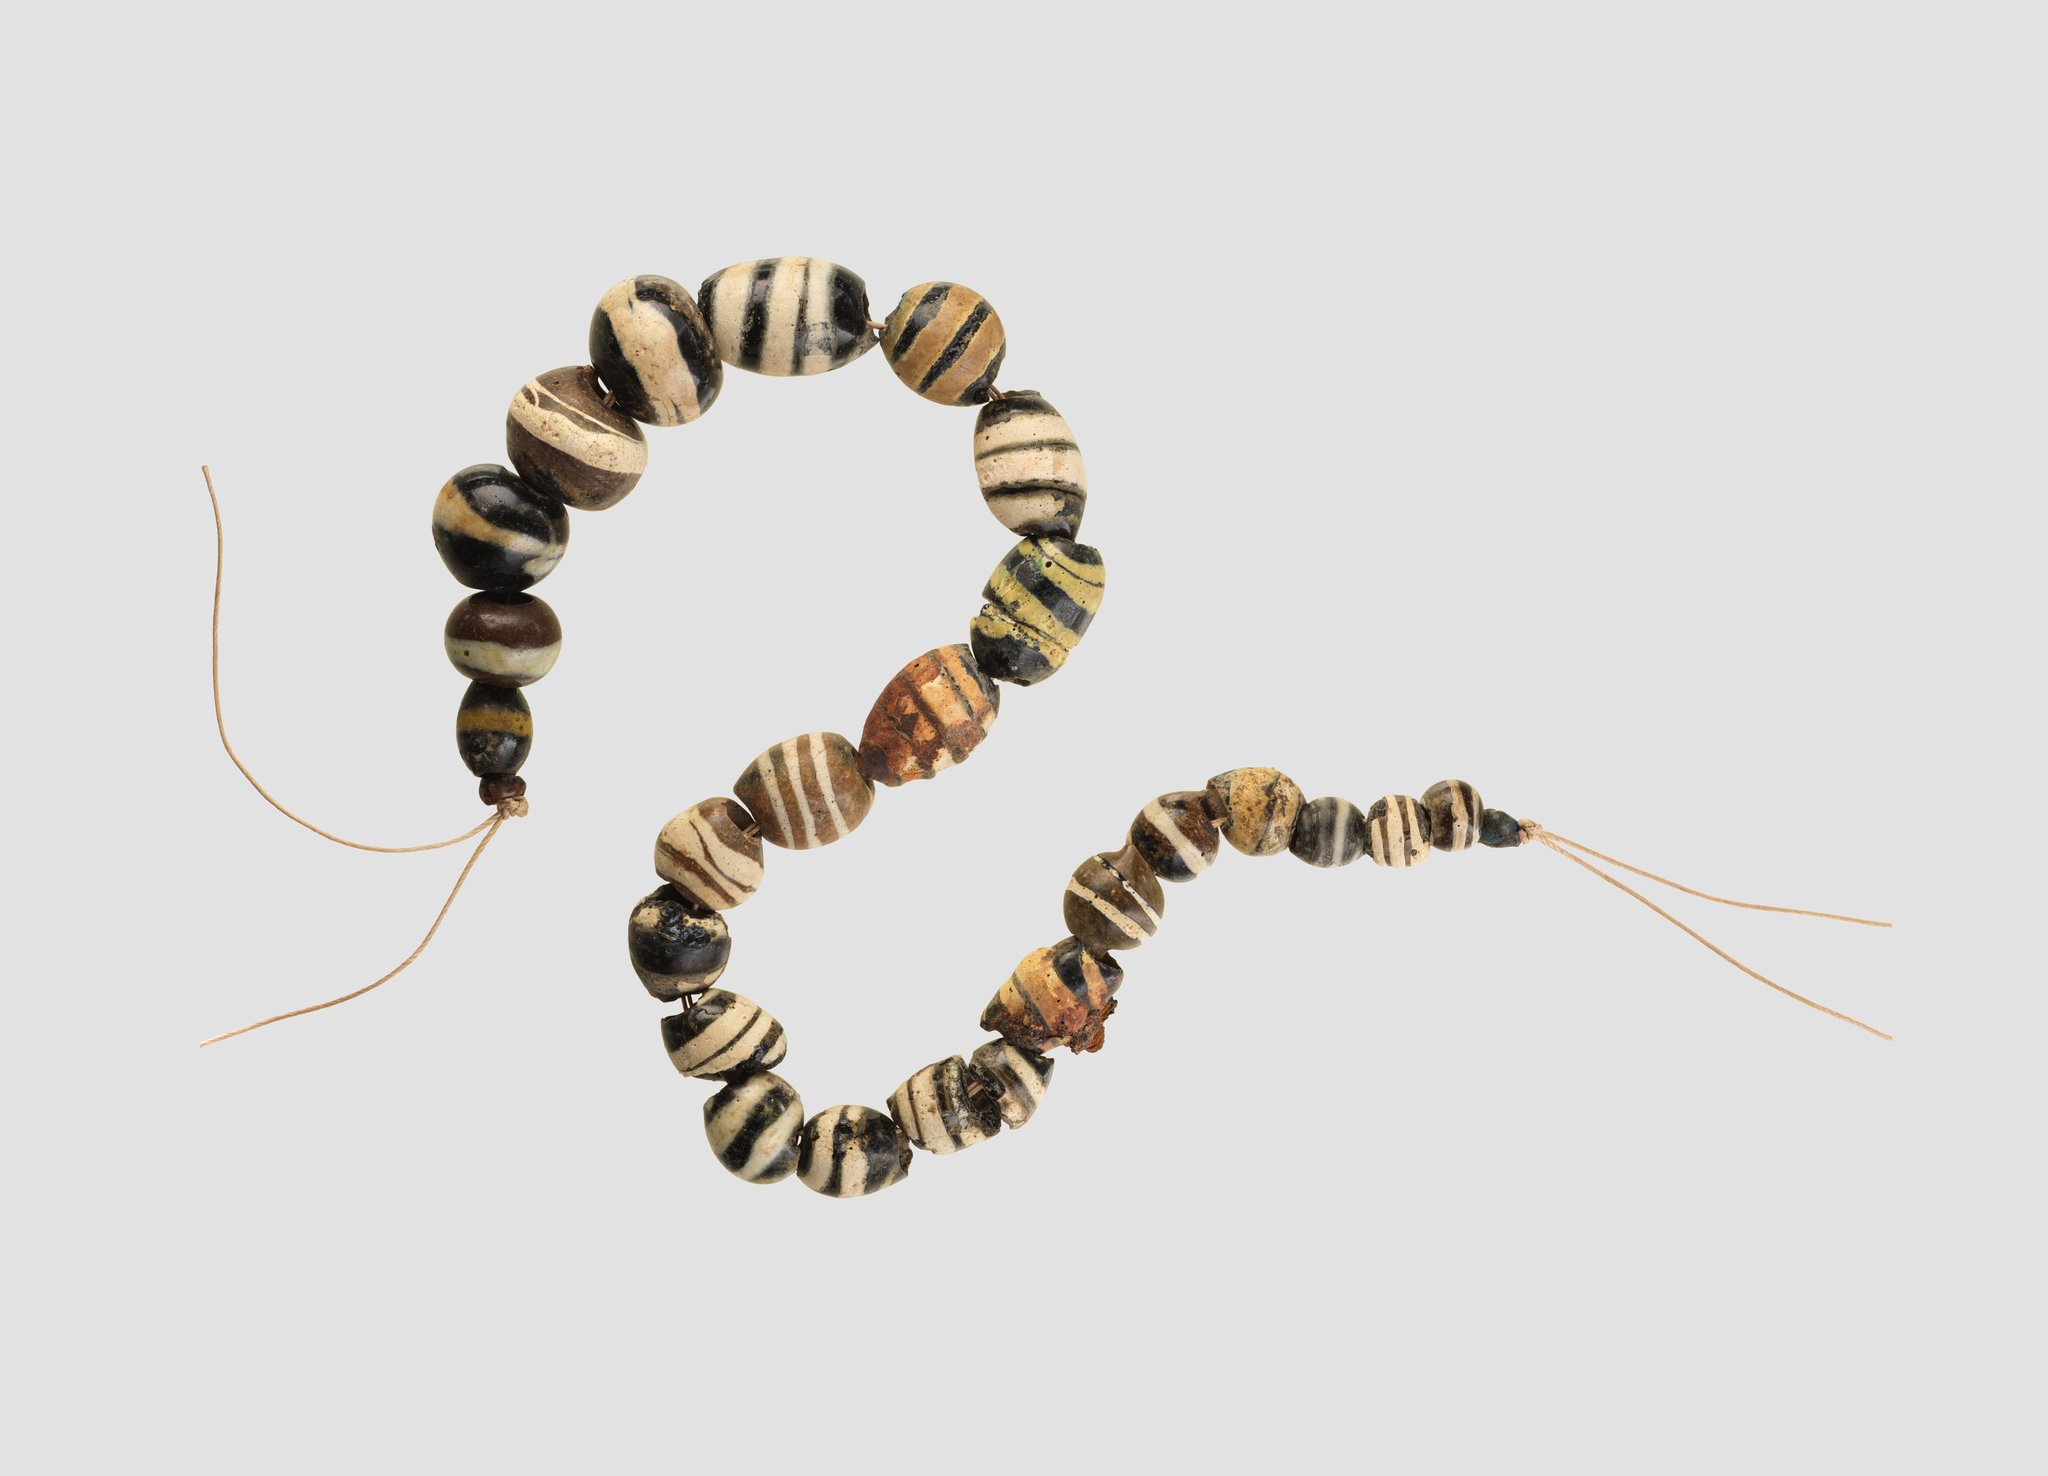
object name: bead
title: Beads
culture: iranian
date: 900-801 BCE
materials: glass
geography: iran